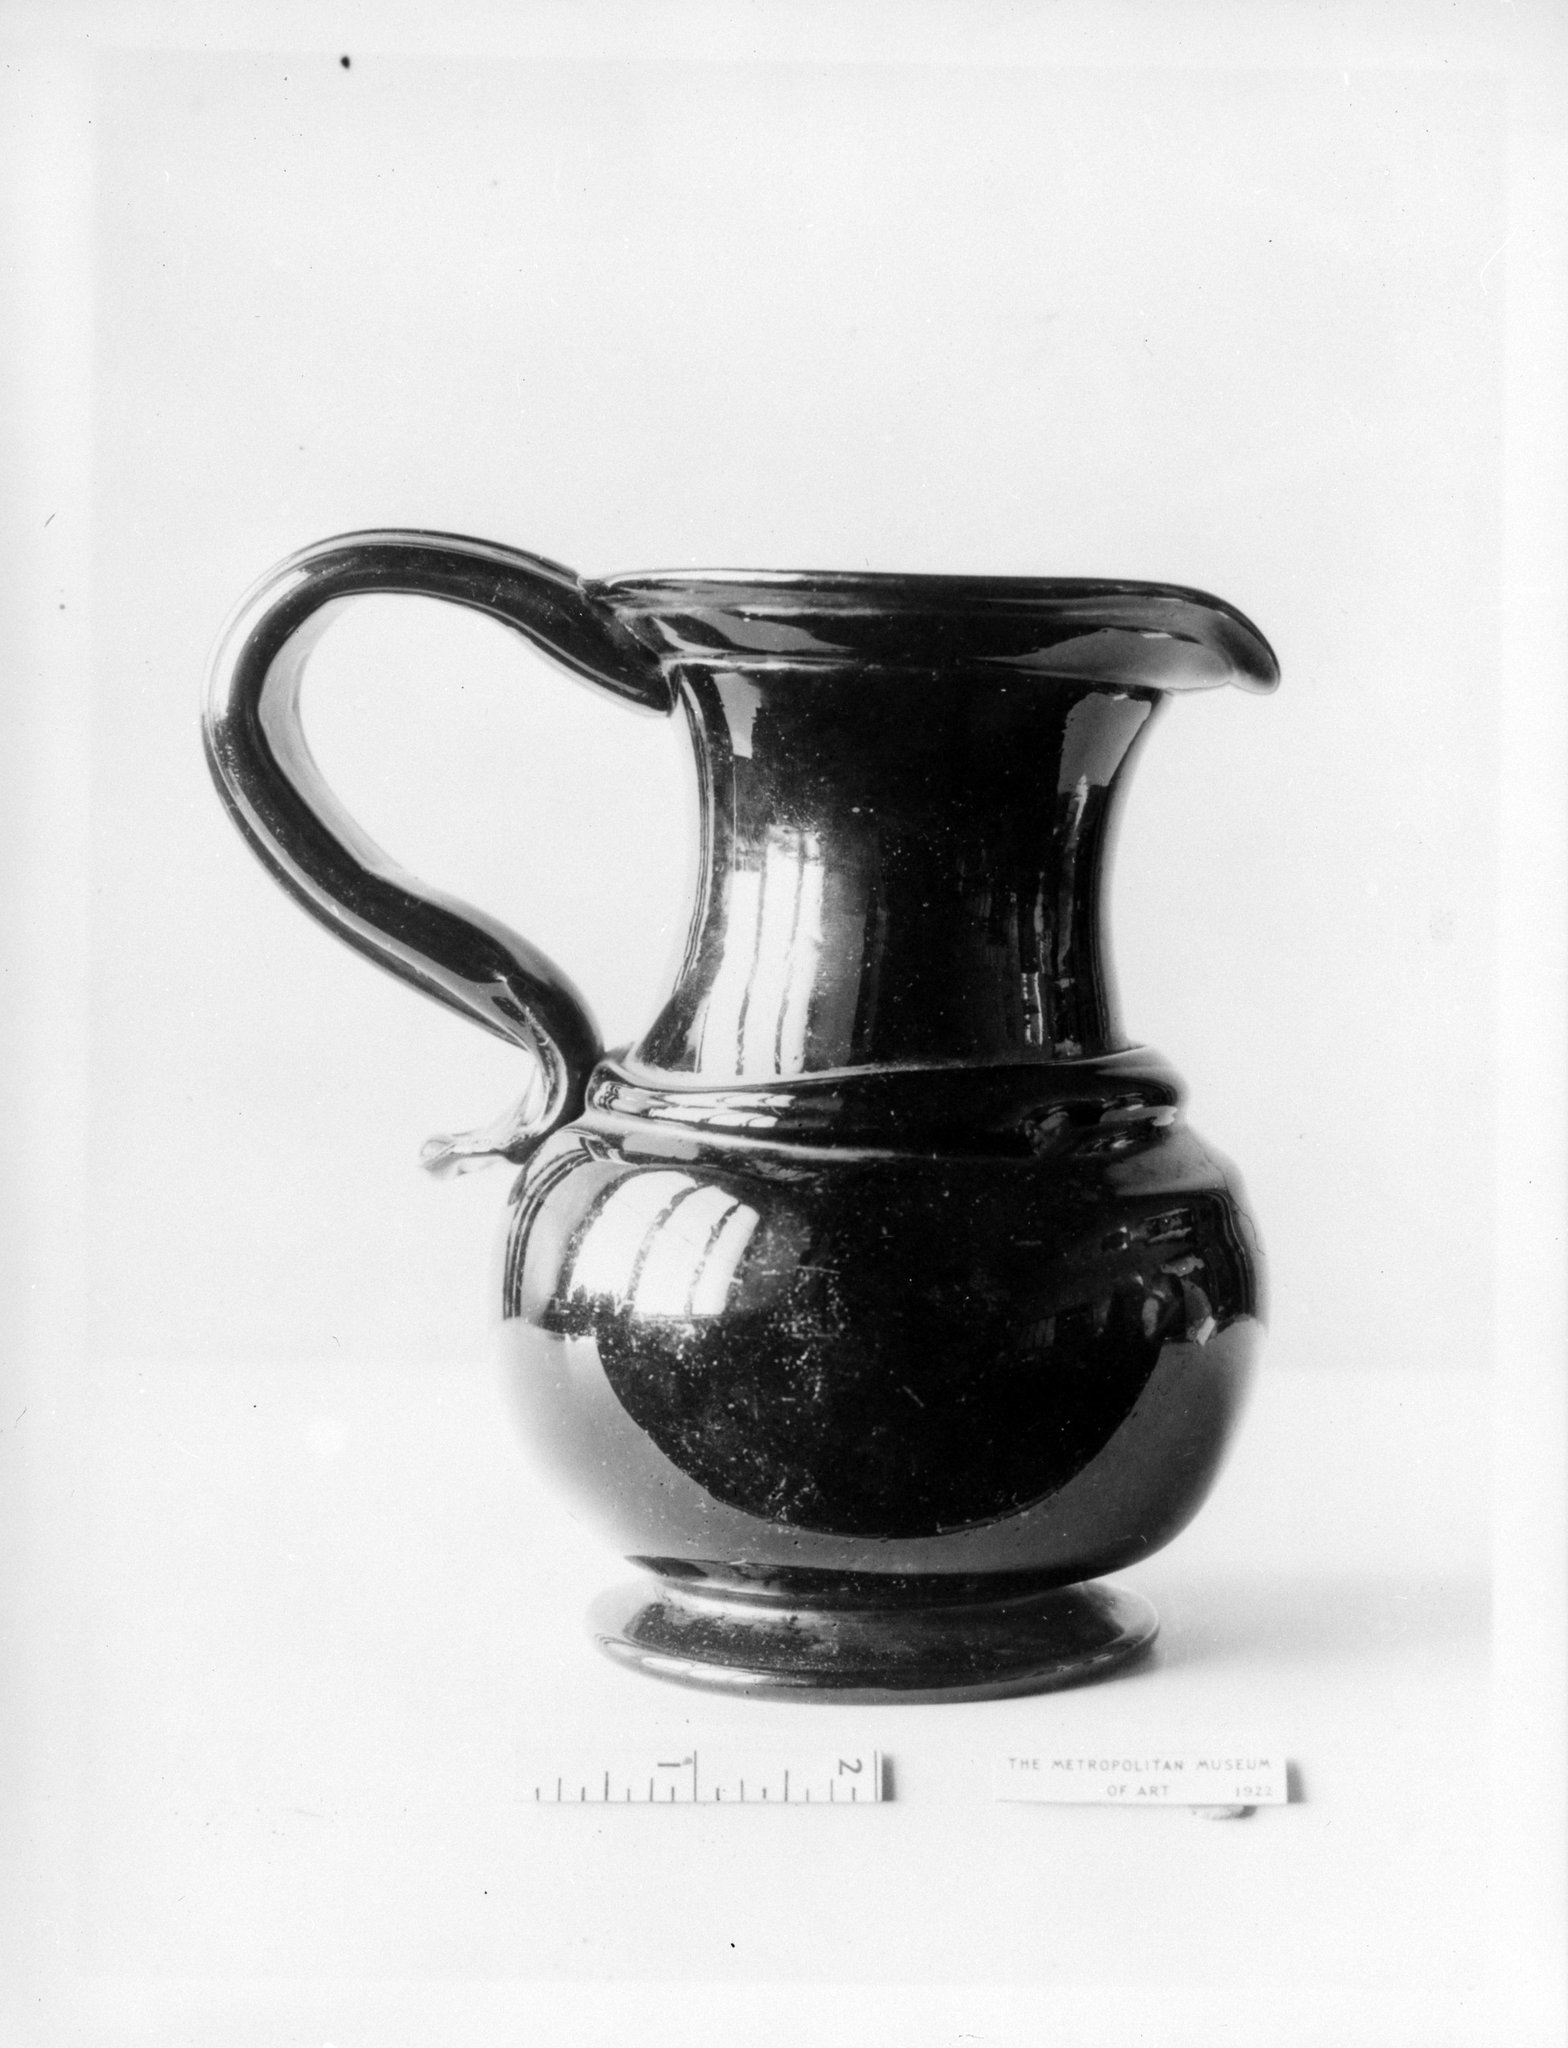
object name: pitcher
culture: american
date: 1700-1800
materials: amber, glass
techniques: glassblowing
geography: united states